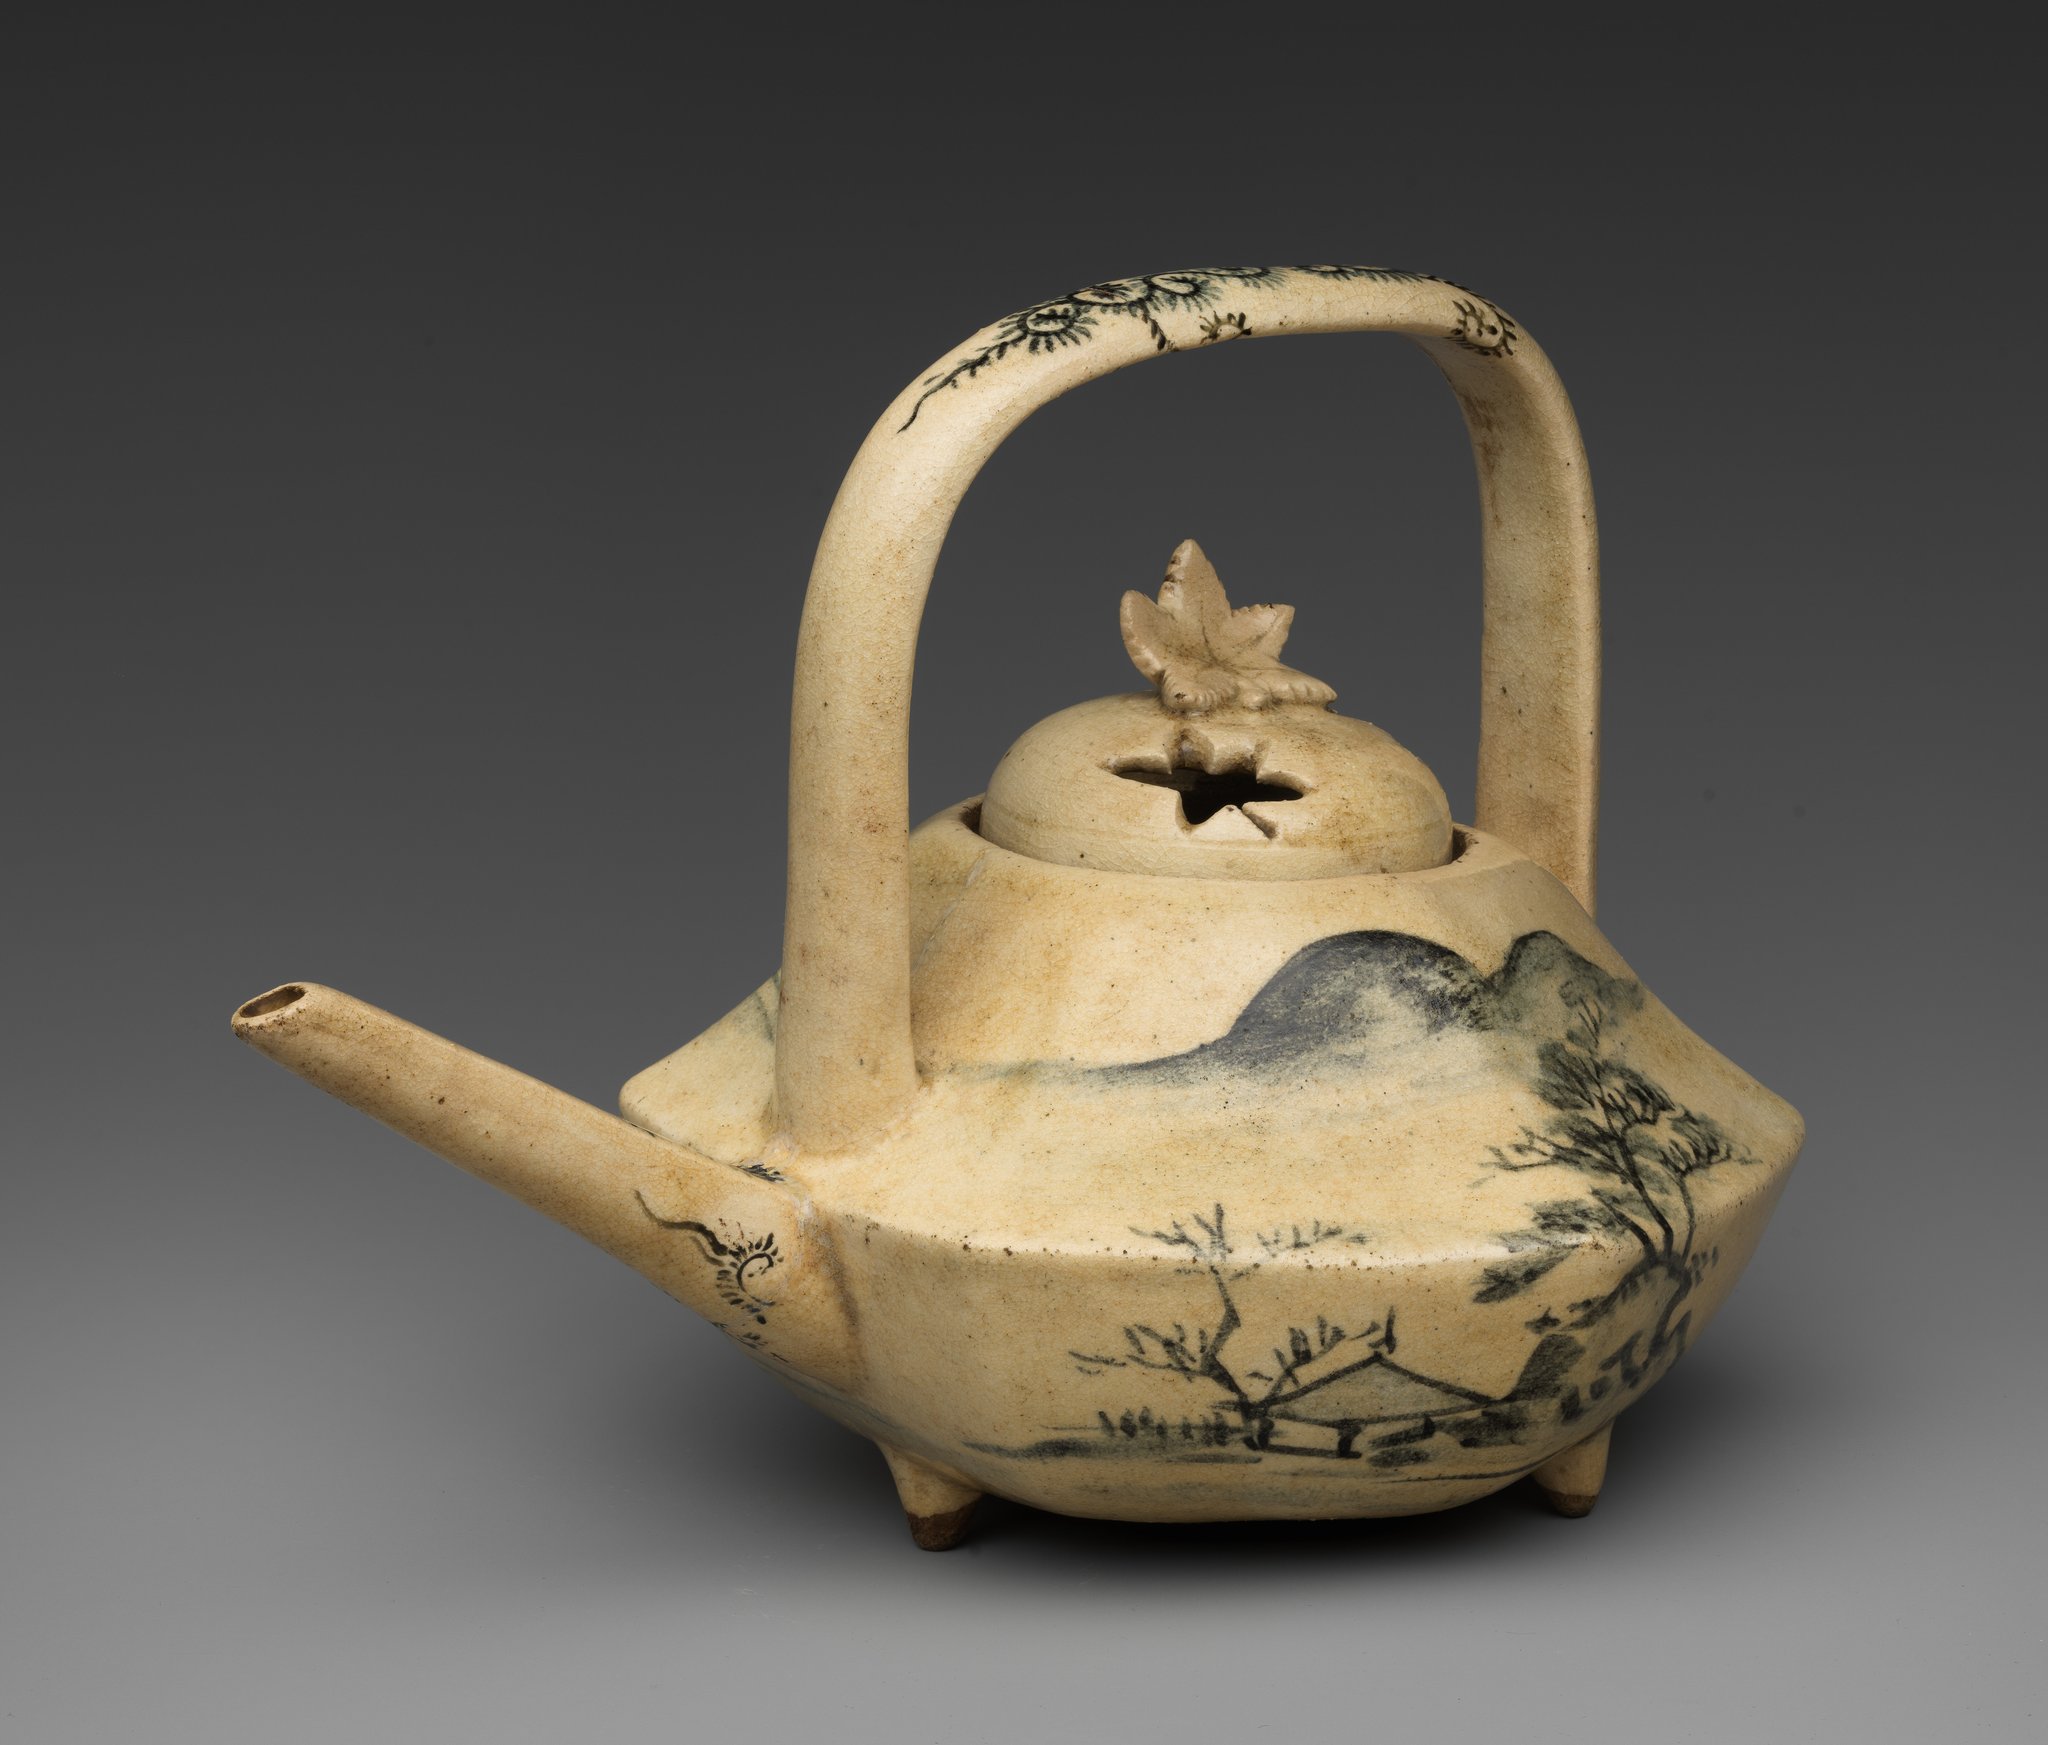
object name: teapot with cover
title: Teapot and Cover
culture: japanese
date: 1701-1800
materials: glaze, pottery